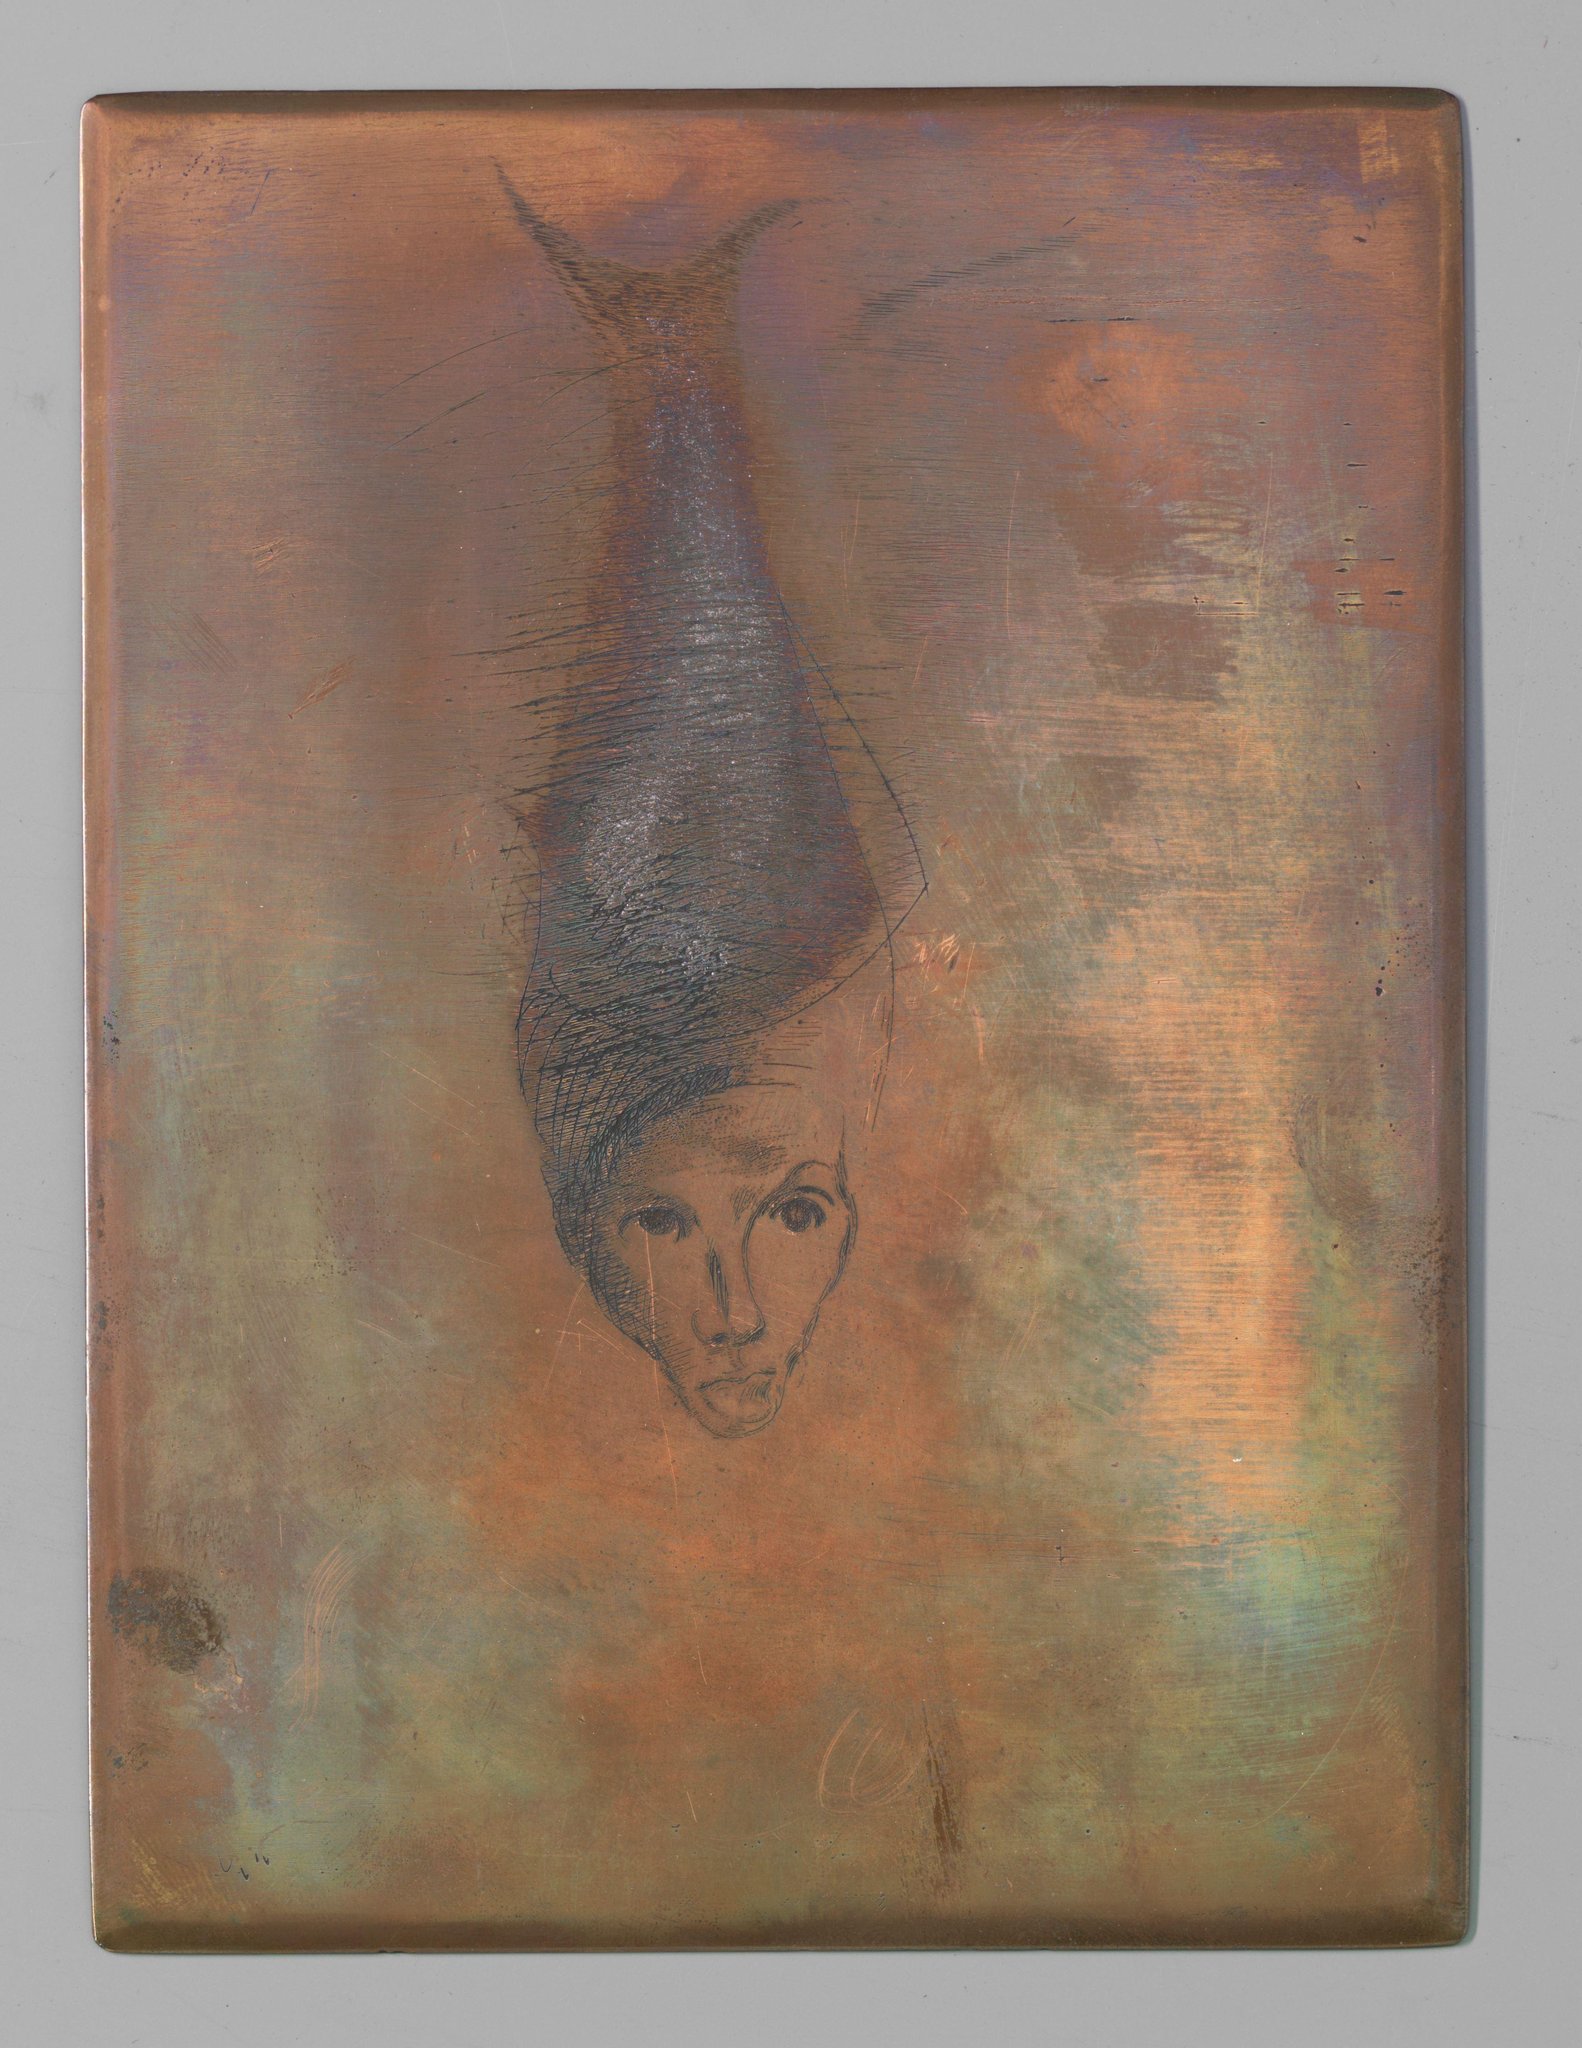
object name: copper plate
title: Sciapode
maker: odilon redon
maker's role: draughtsman, painter, print maker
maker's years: 1840-1916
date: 1892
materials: copper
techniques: etching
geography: france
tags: monsters ~ fishes, 'scopodes', 'sciapodes', i.e. beings with one leg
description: Gemaakt in 1892, toen werden er slechts enkele afdrukken van gemaakt. Volgens Mellério werd de plaat in 1912 door de Nederlandse uitgevers Artz & De Bois gekocht, die er toen een oplage van 39 van drukten (dit klopt niet, moet 38 zijn). Artz & De Bois schonken de plaat in 1913 aan het Rijksprentenkabinet.